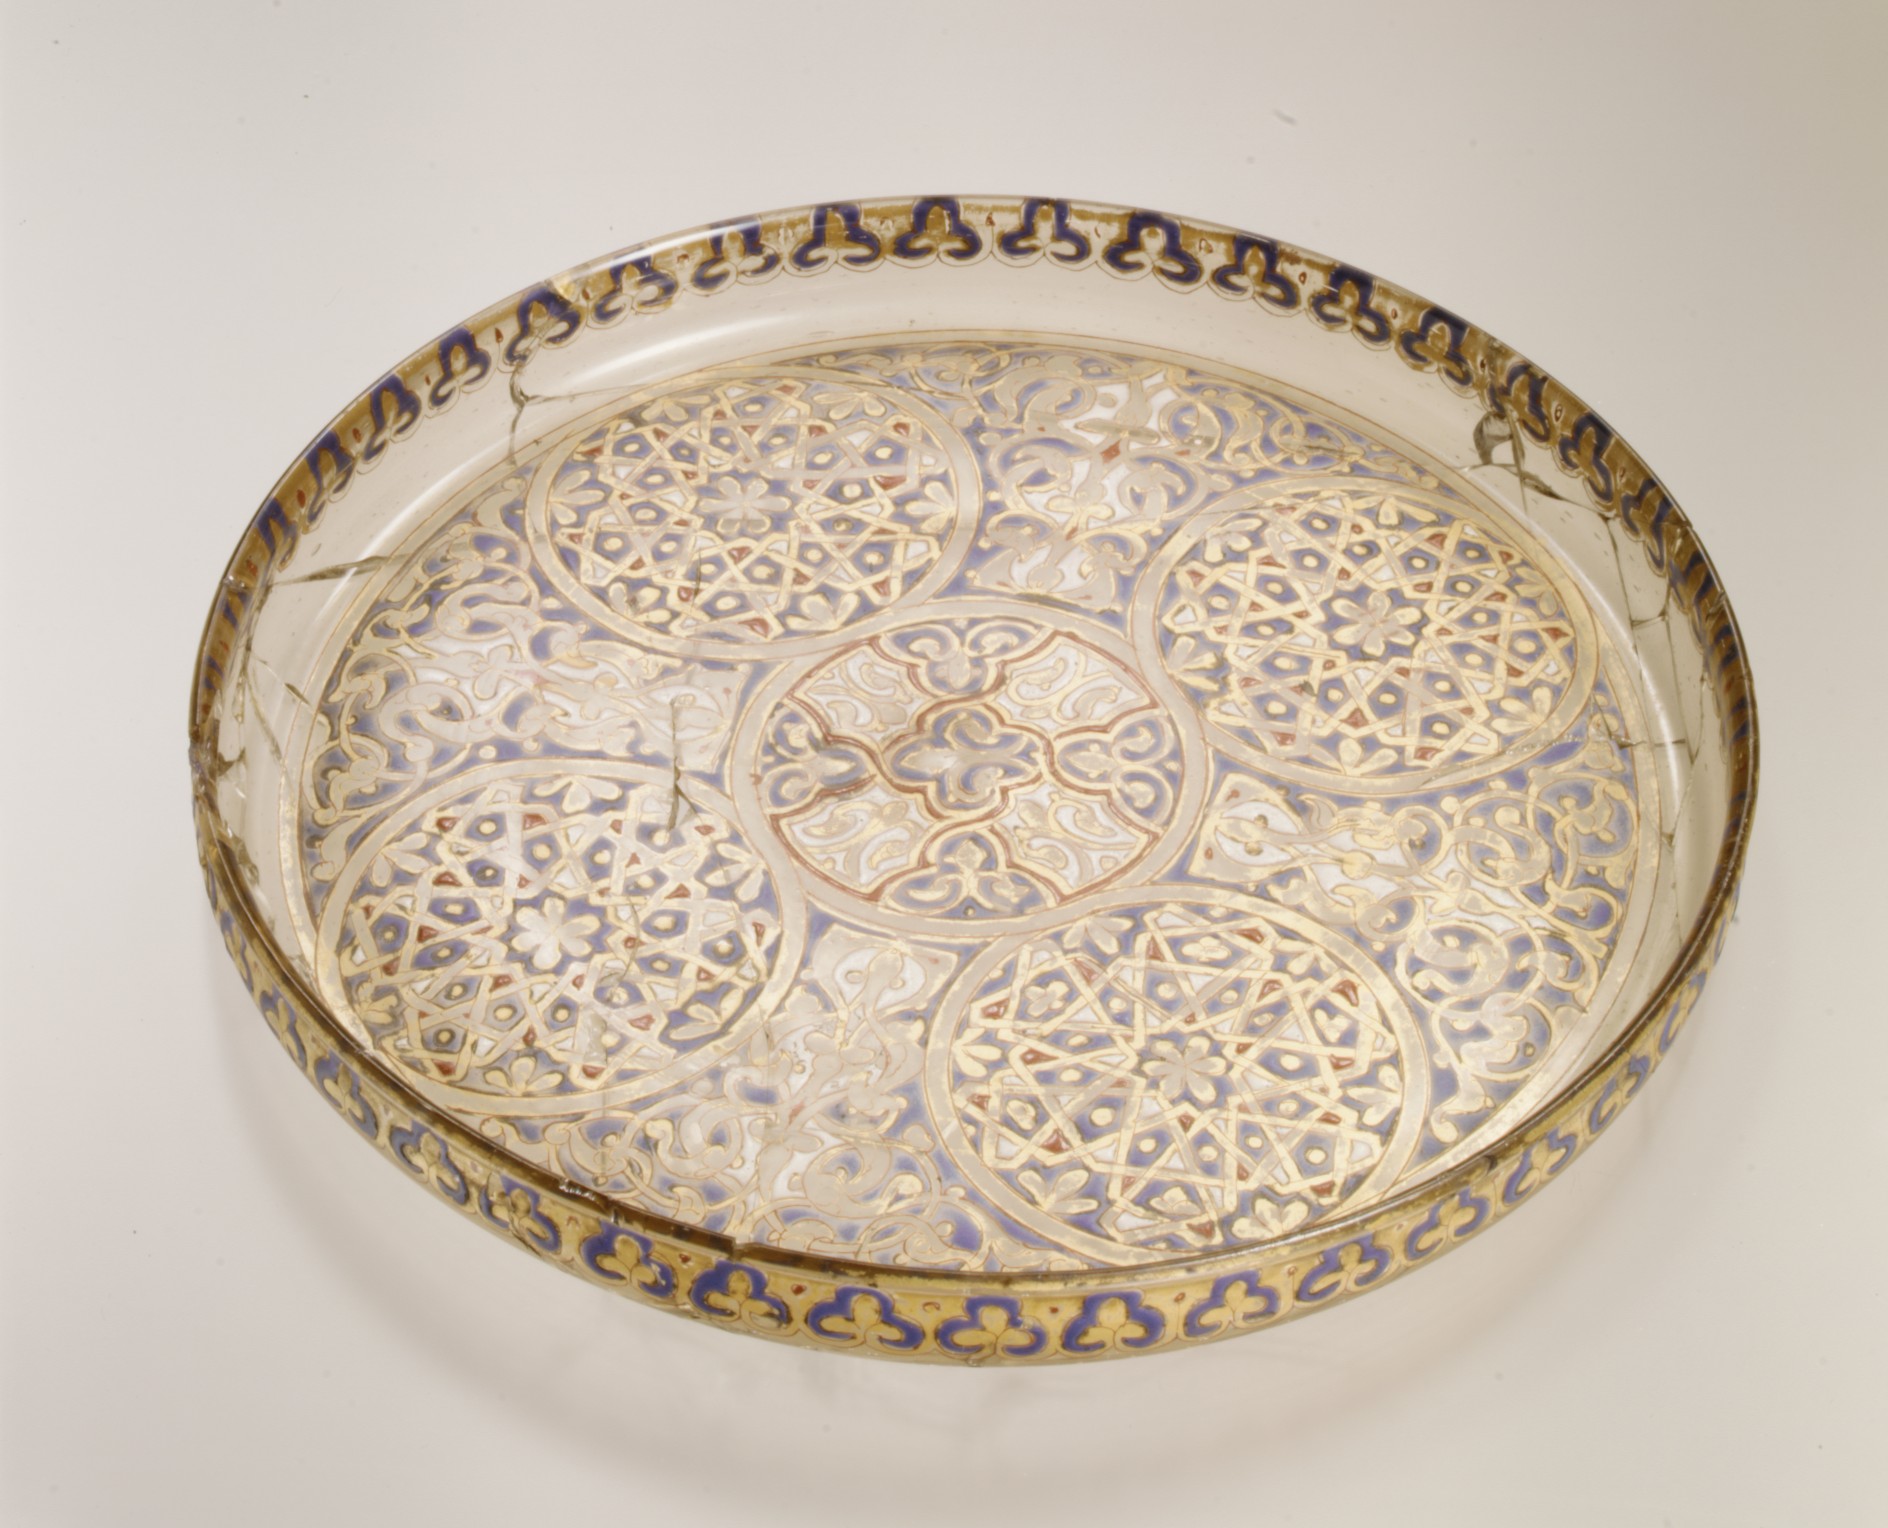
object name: plate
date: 1350-1357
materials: glass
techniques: enamel, glassblowing, gilding, tooling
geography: syria